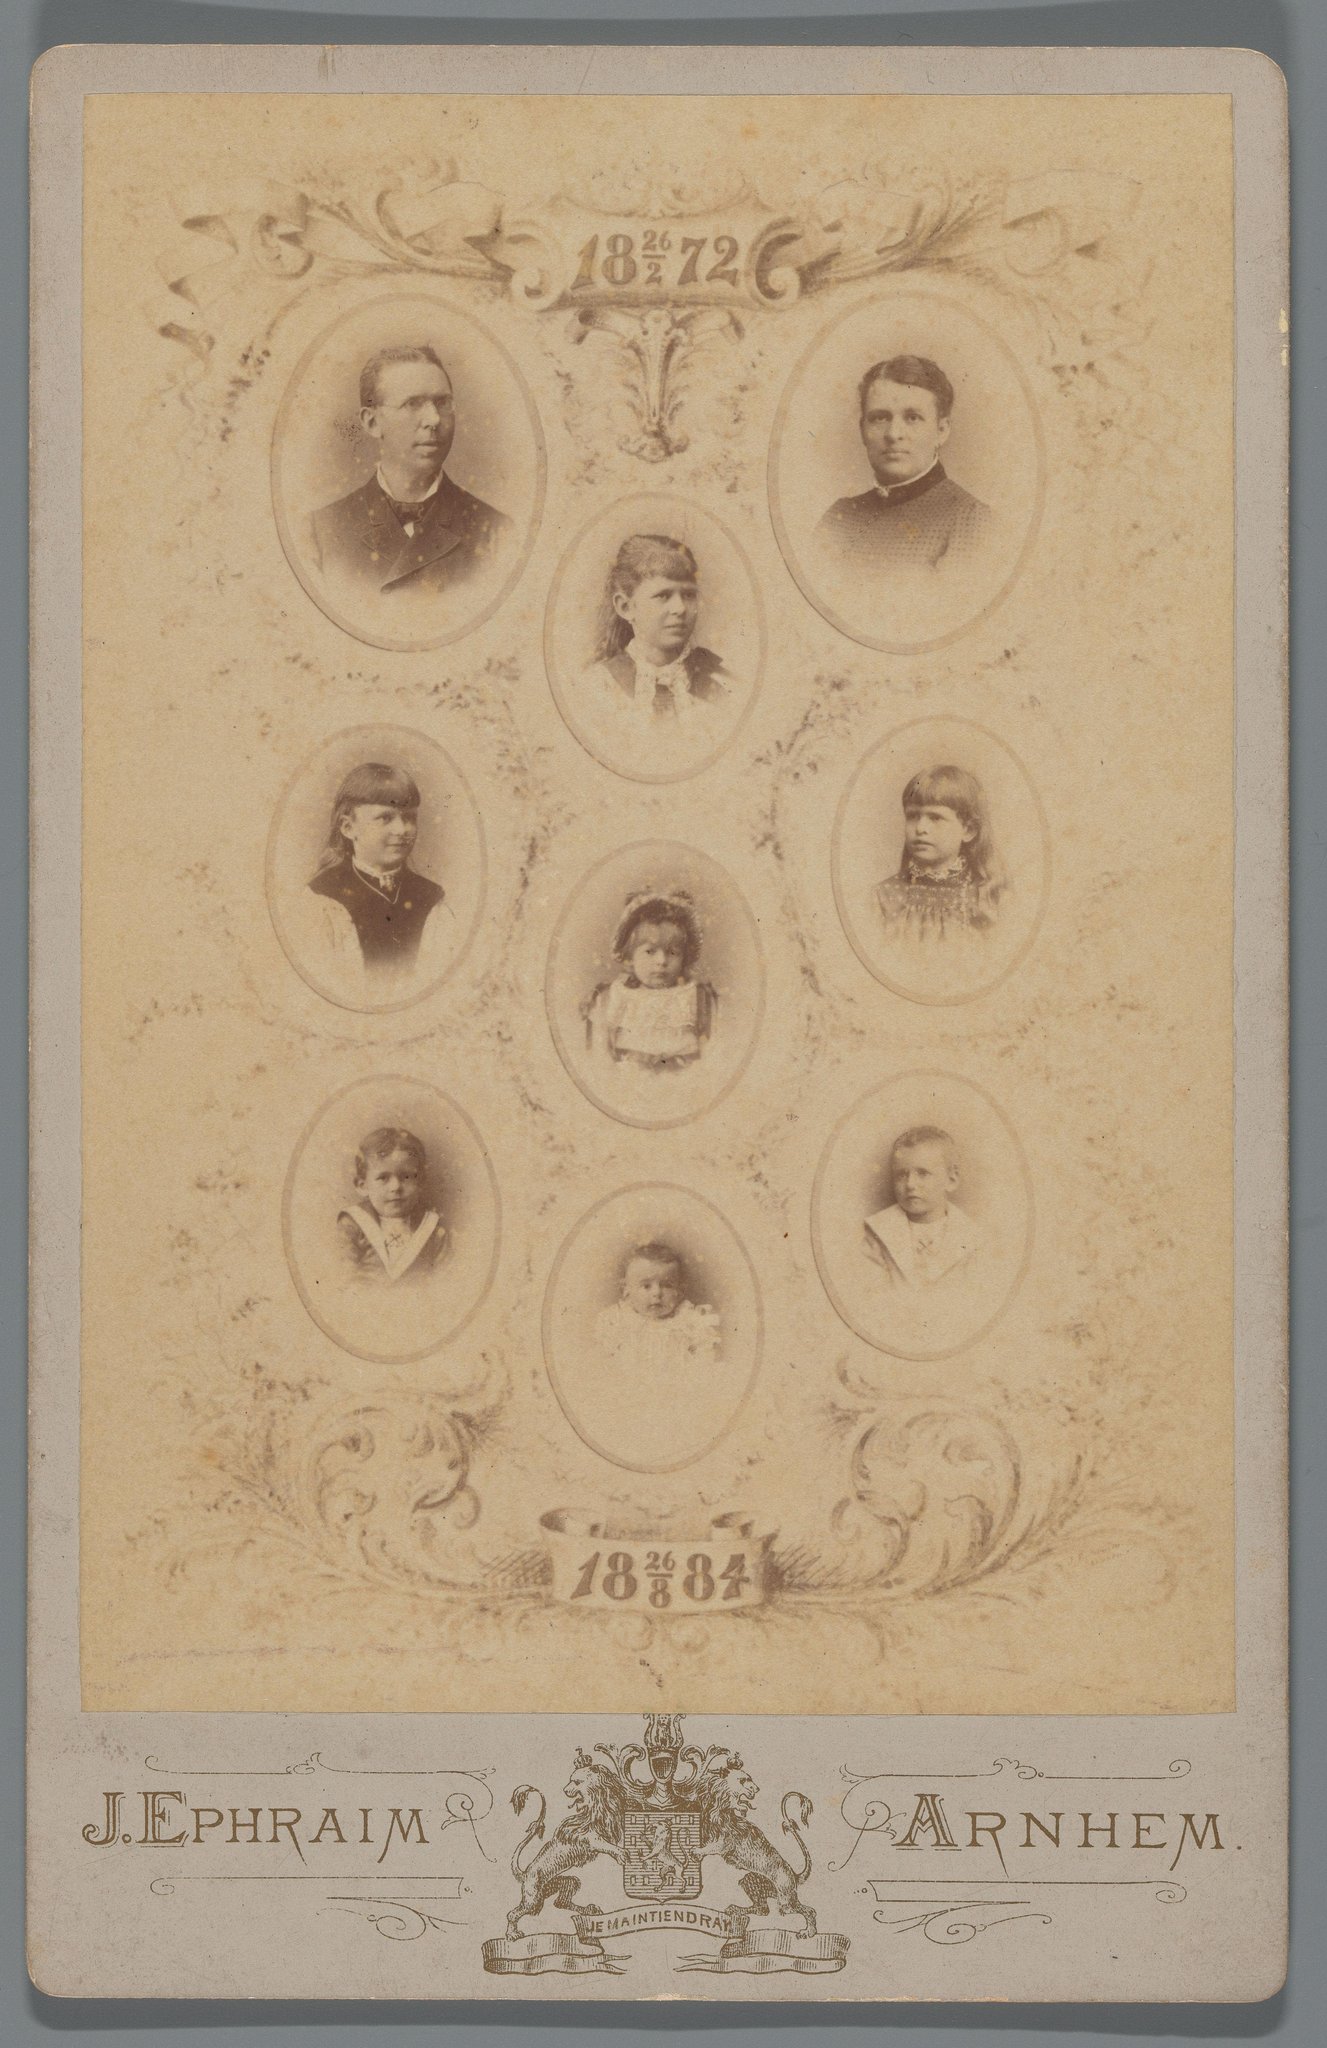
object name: cabinet photograph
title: Composietportret van de familie Van den Berg ter gelegenheid van het koperen huwelijk in 1884 van H.P.J. van den Berg en Francina Schas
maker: johannes ephraim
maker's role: fotograaf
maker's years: 1838-1921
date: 1884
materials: cardboard, photographic support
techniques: albumen print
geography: arnhem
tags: rotterdam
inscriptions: name, name: ‘J.EPHRAIM ARNHEM.’, name: ‘photo koperen bruiloft / grootvader & grootmoeder v.d Berg / Schas / tante Dé / ... / tante Leo / Oom frans / " Jan / tante Jeanne / oom Willem’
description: Composietportret met 8 portretten in ovalen. Links H.P.J. van den Berg, daarnaast F. Schas en daaronder zeven kinderen.